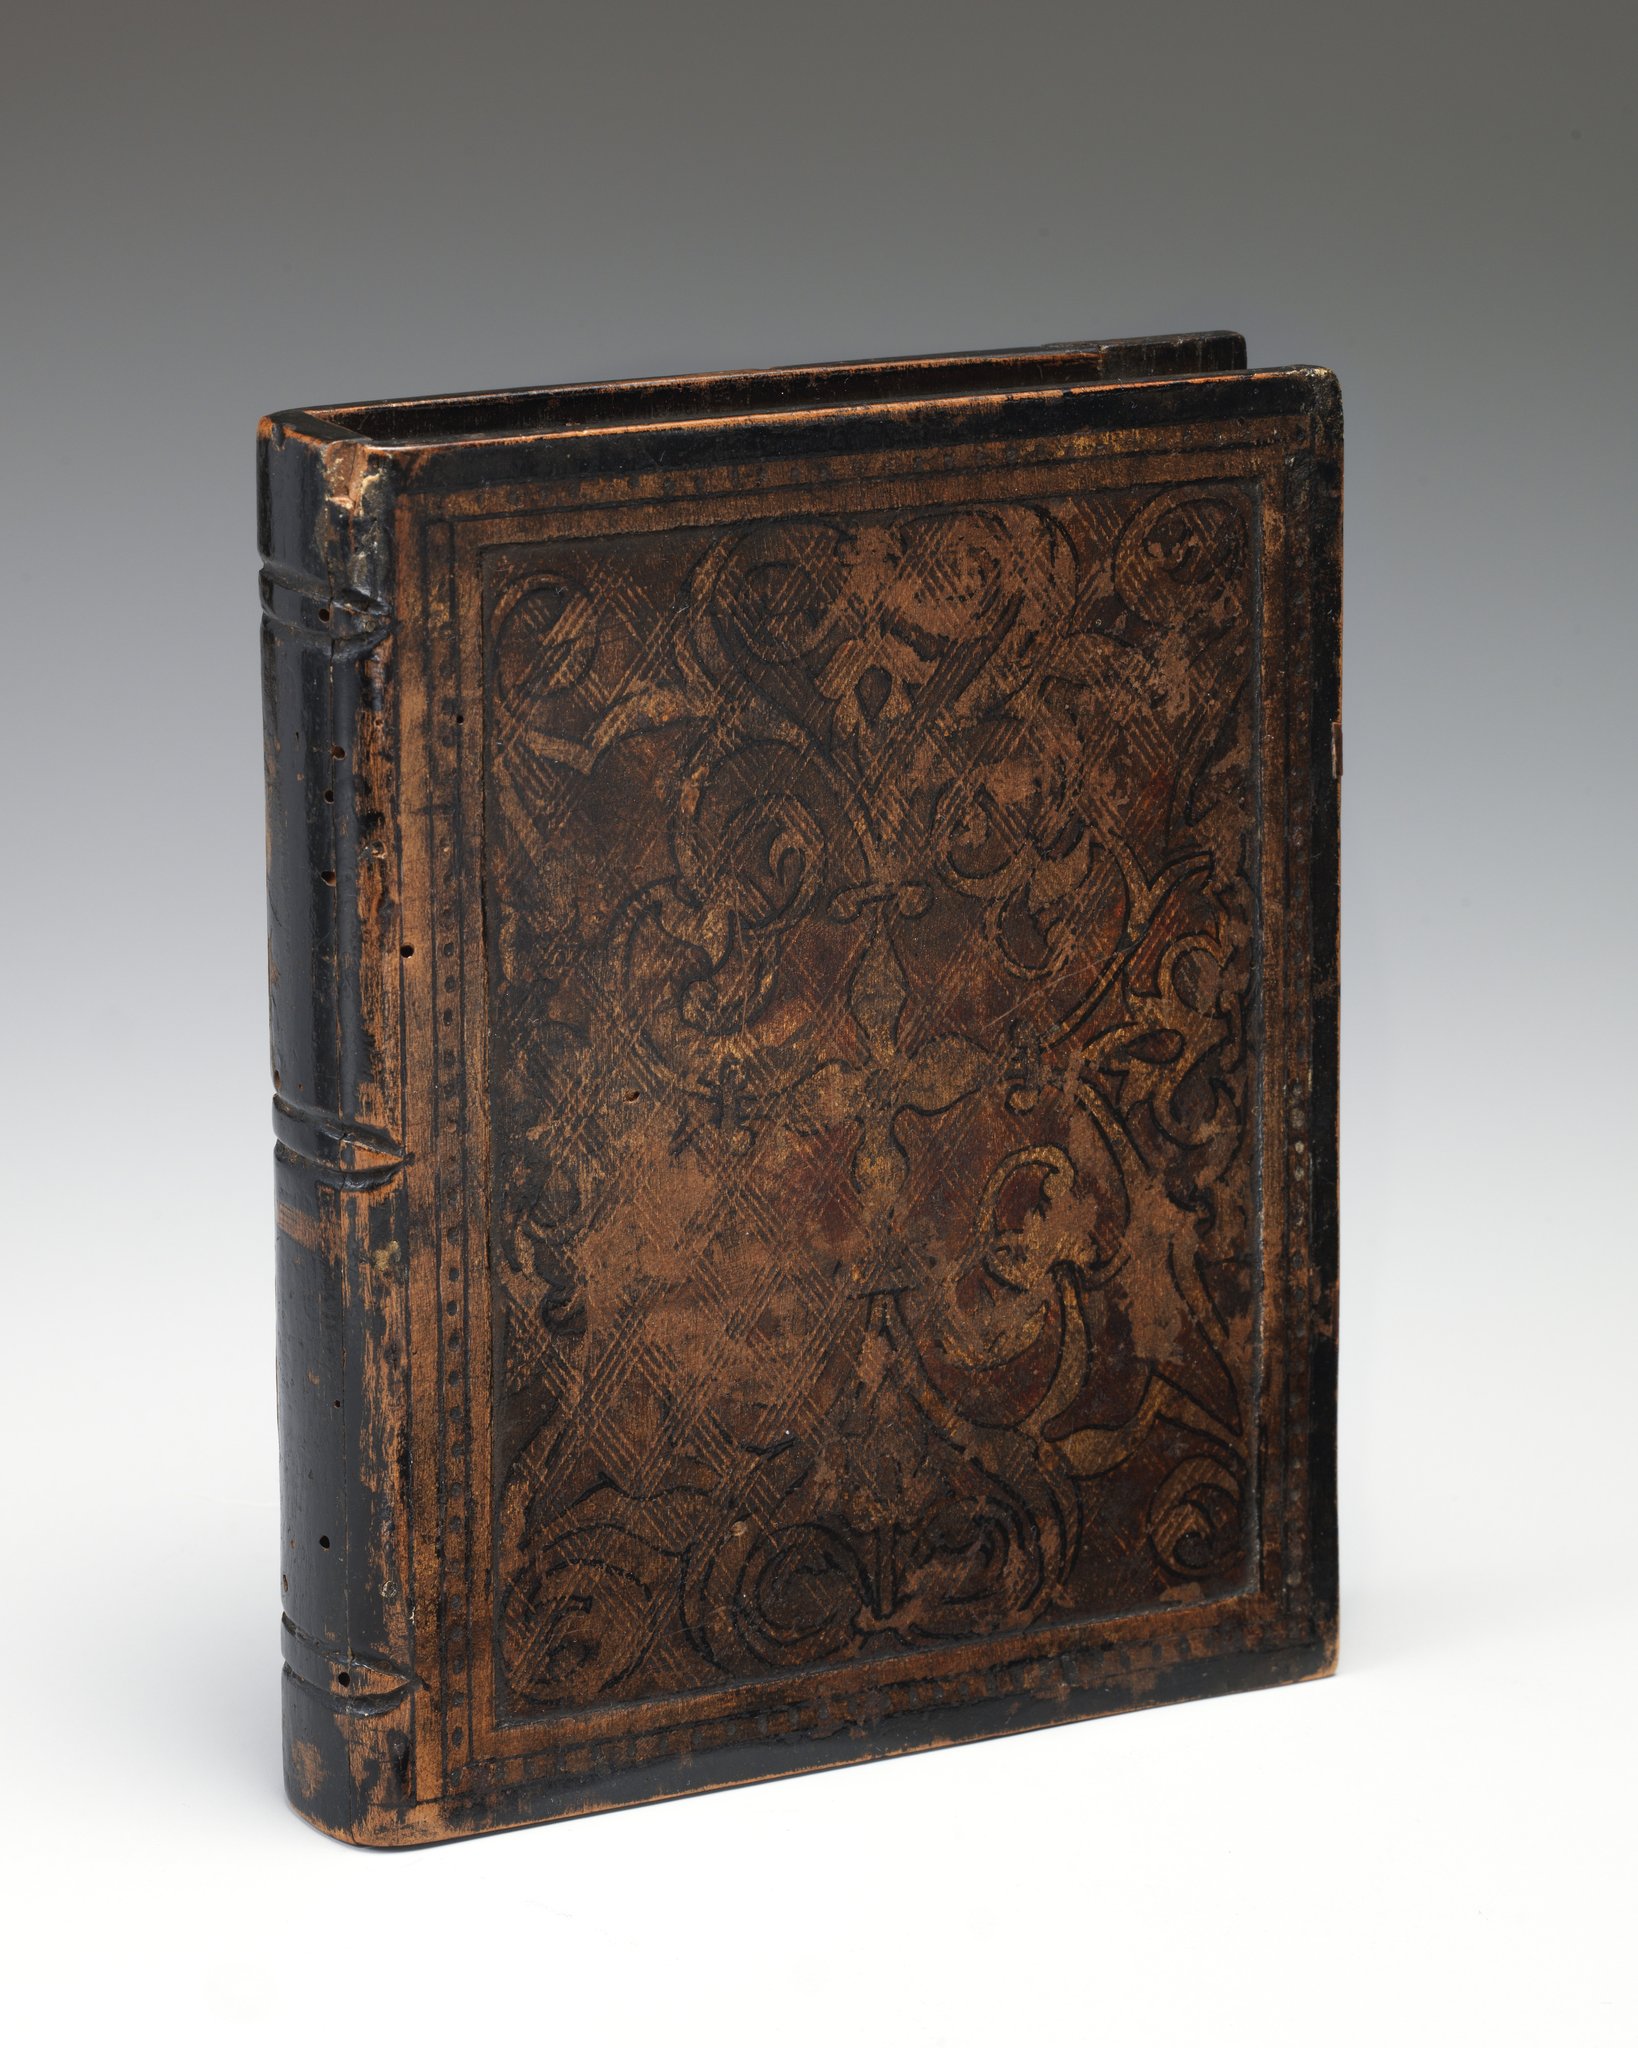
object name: box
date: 1601-1633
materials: gilt, wood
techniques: painting